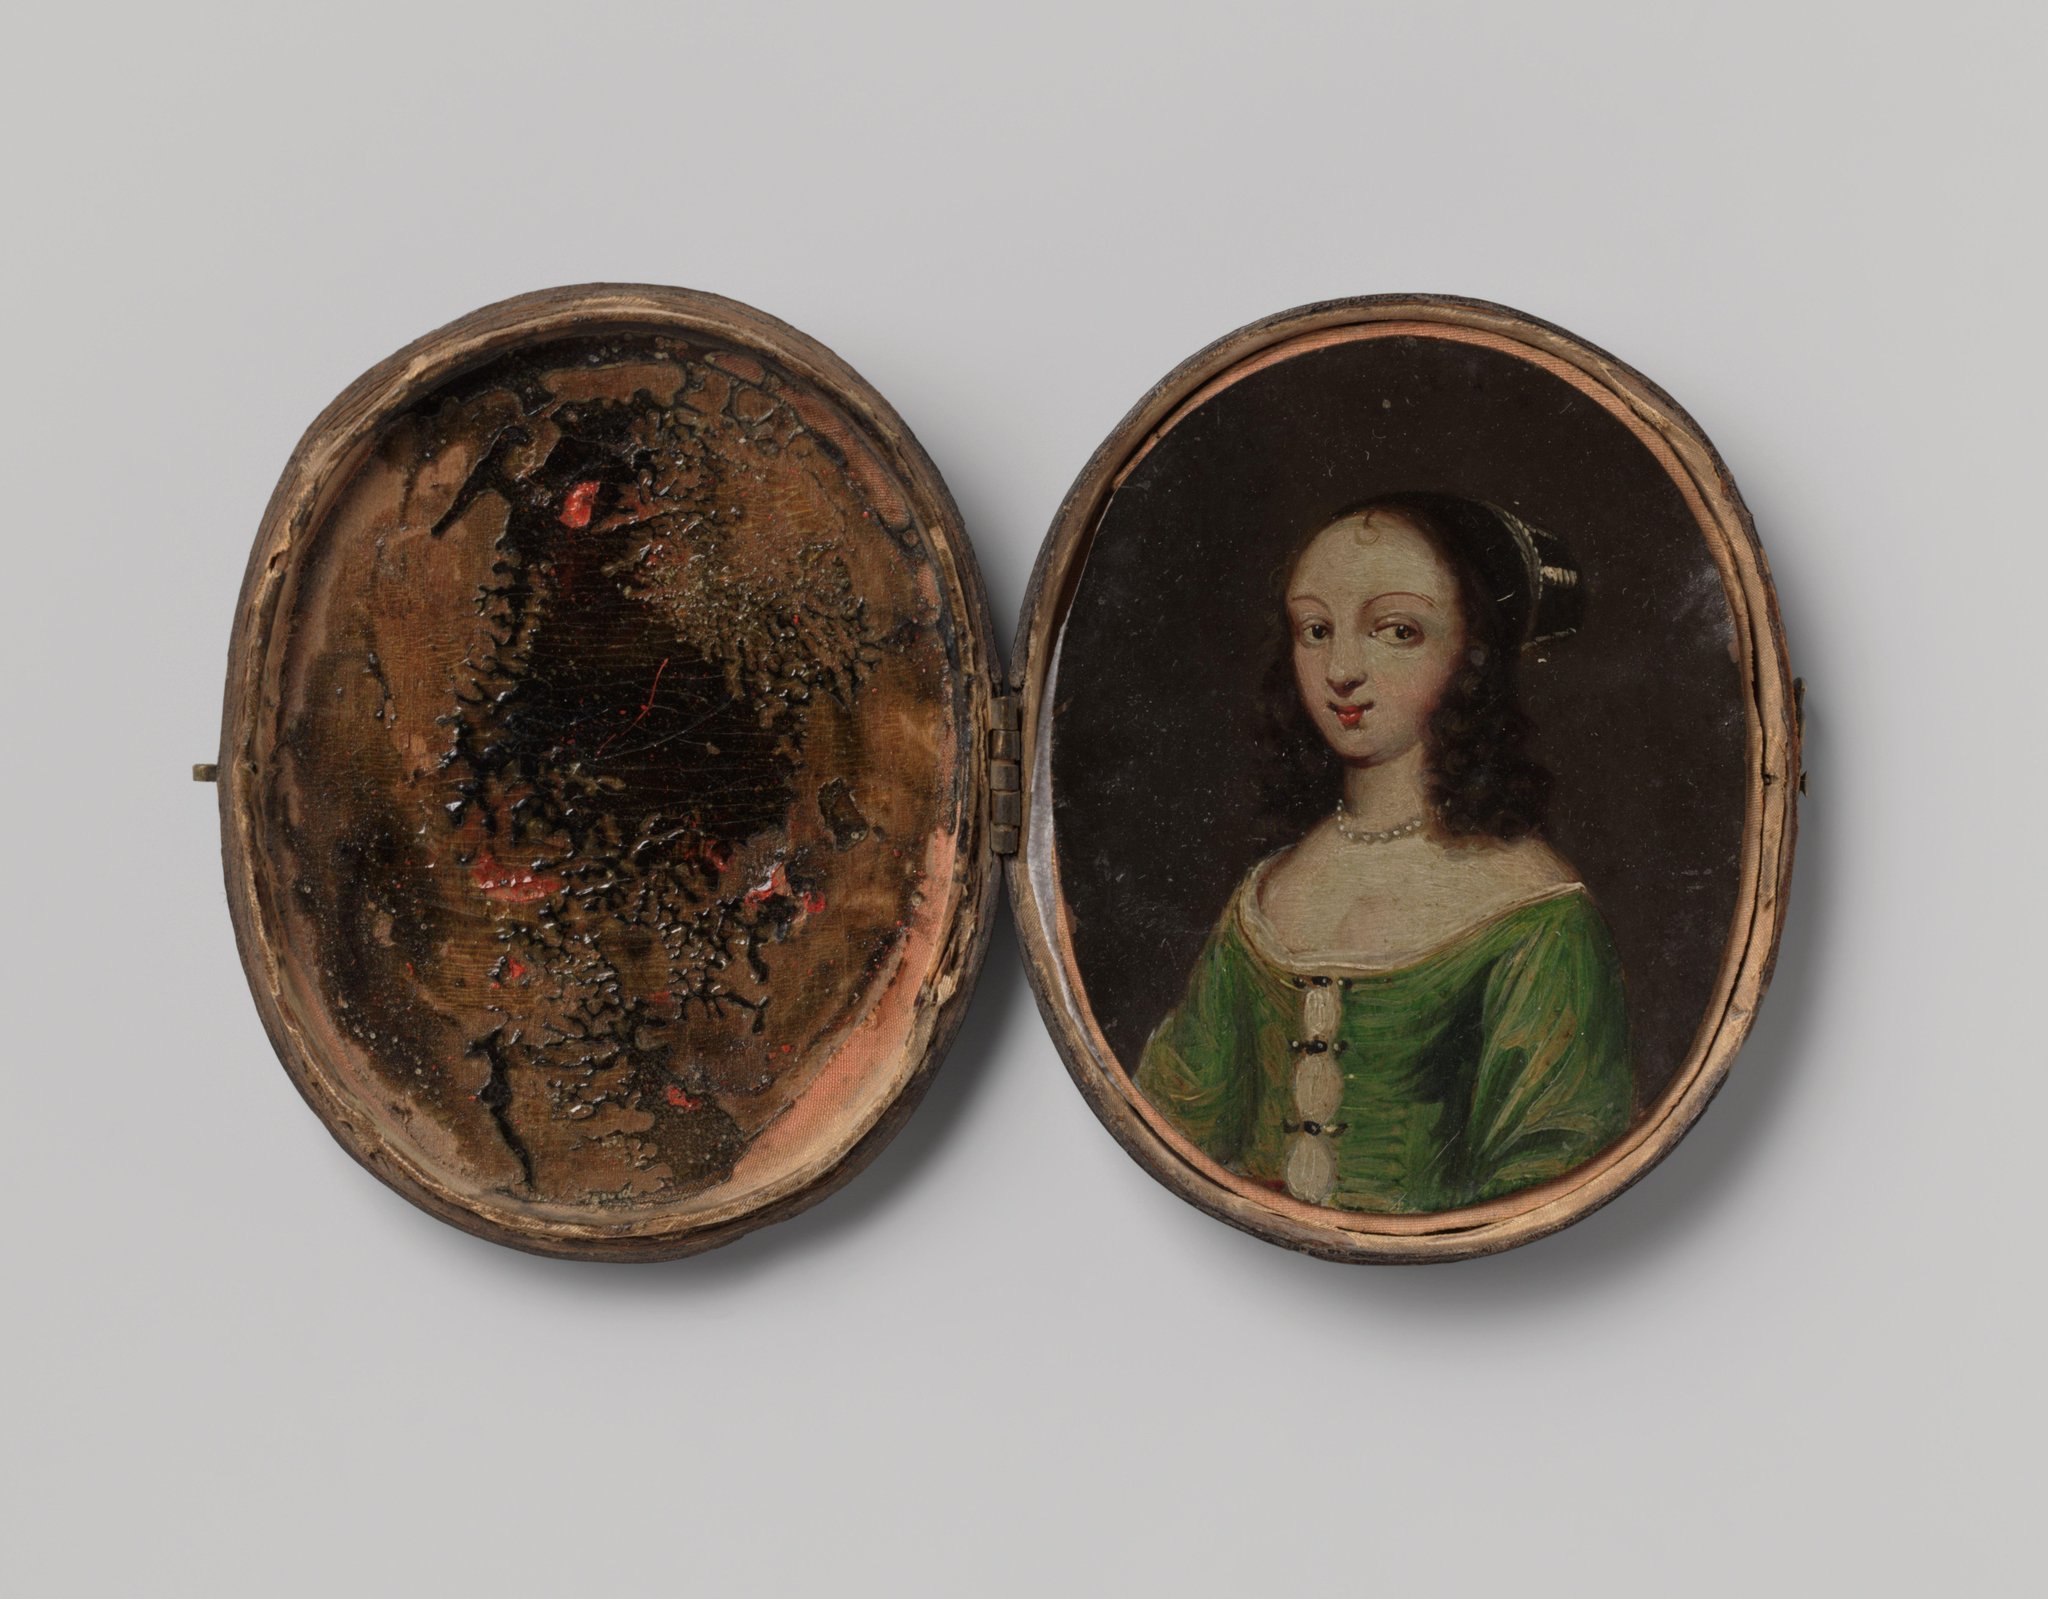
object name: transparency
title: Ovale doos waarin een vrouwenportret en dertien transparantjes beschilderd met verschillende kostuums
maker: Anonymous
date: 1642-1652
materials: copper, leather, metal, oil, paint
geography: northern netherlands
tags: berlin, louise henriëtte (prinses van oranje), the hague, henriëtte catharina (prinses van oranje)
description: Ovale doos van zwart leer beschilderd met tempera. Hierin een vrouwenportret in olieverf op koper en dertien transparantjes van mica beschilderd met verschillende kostuums. De verkledingen vertonen bijvoorbeeld huik met berthe-kraag, als vorstin met paarlenkroontje en hermelijnen schoudermantel, als stadsdame met bontomrande vlieger, hoofddoek en zwarte baret, als man met pluimhoed, sjerp, snor en sikje etc. Het portret stelt mogelijk een vrouwelijk lid van het huis Oranje Nassau voor: Louise Henriette of Henriette Catharina, dochters van Frederik Hendrik en Amalia van Solms.